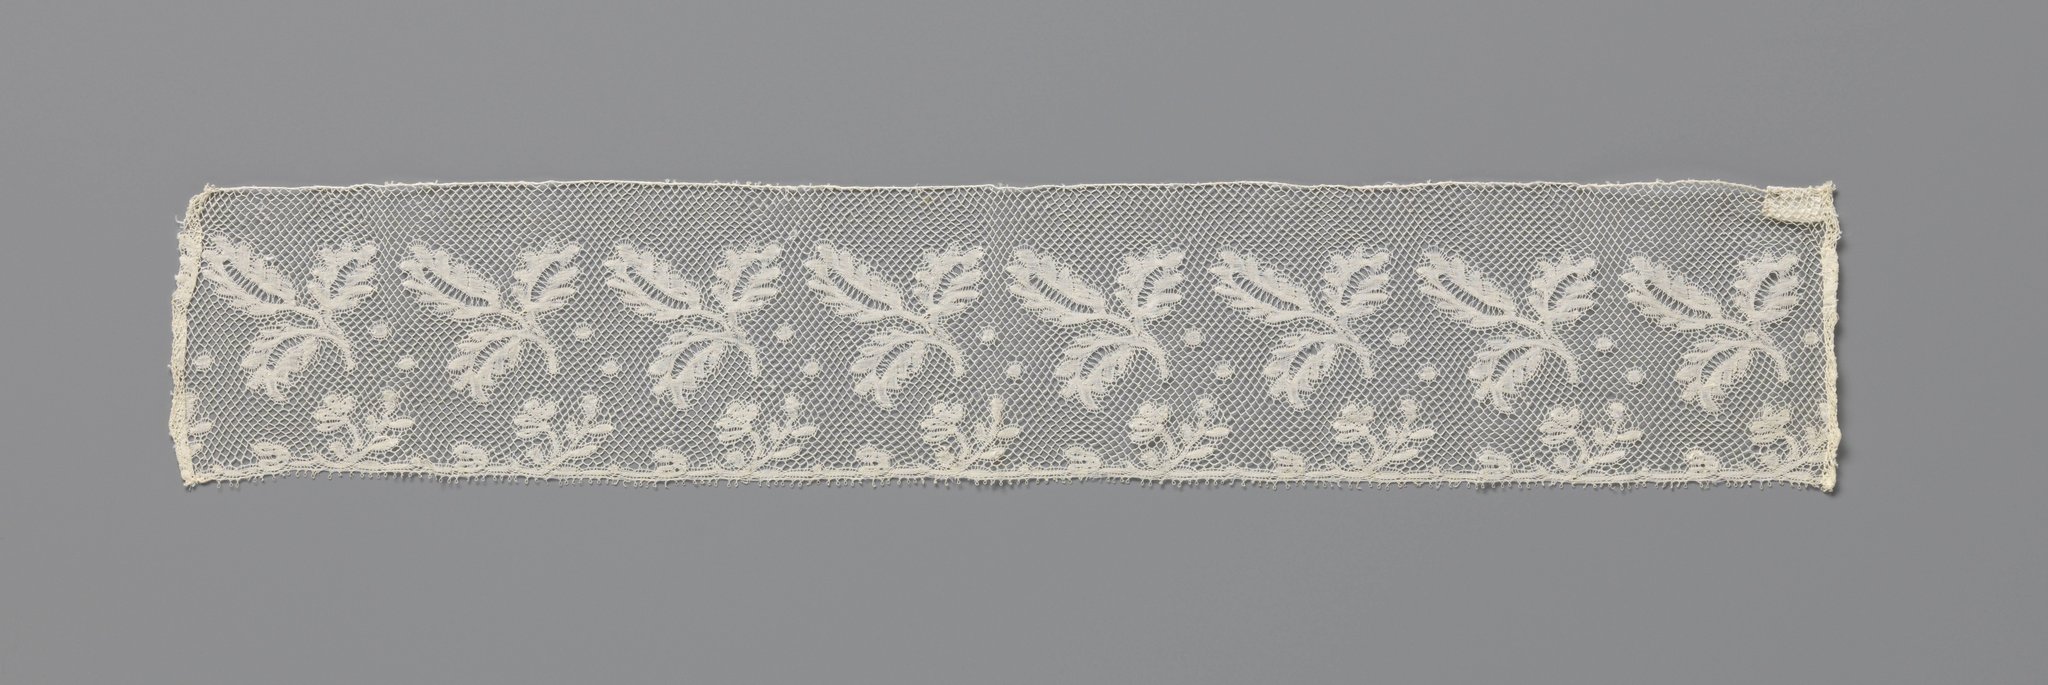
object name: strip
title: Strook kloskant met drieblad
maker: Anonymous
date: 1820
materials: linen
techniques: lace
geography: ieper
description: Op een fijn mazennet staat in de buitenste helft een stijve rij van drie-delige blaadjes, die eenzijdig gericht zijn. Een rechte rand vertoont kleinere, tegengesteld gerichte bloemtakjes. Valenciennes-kant.